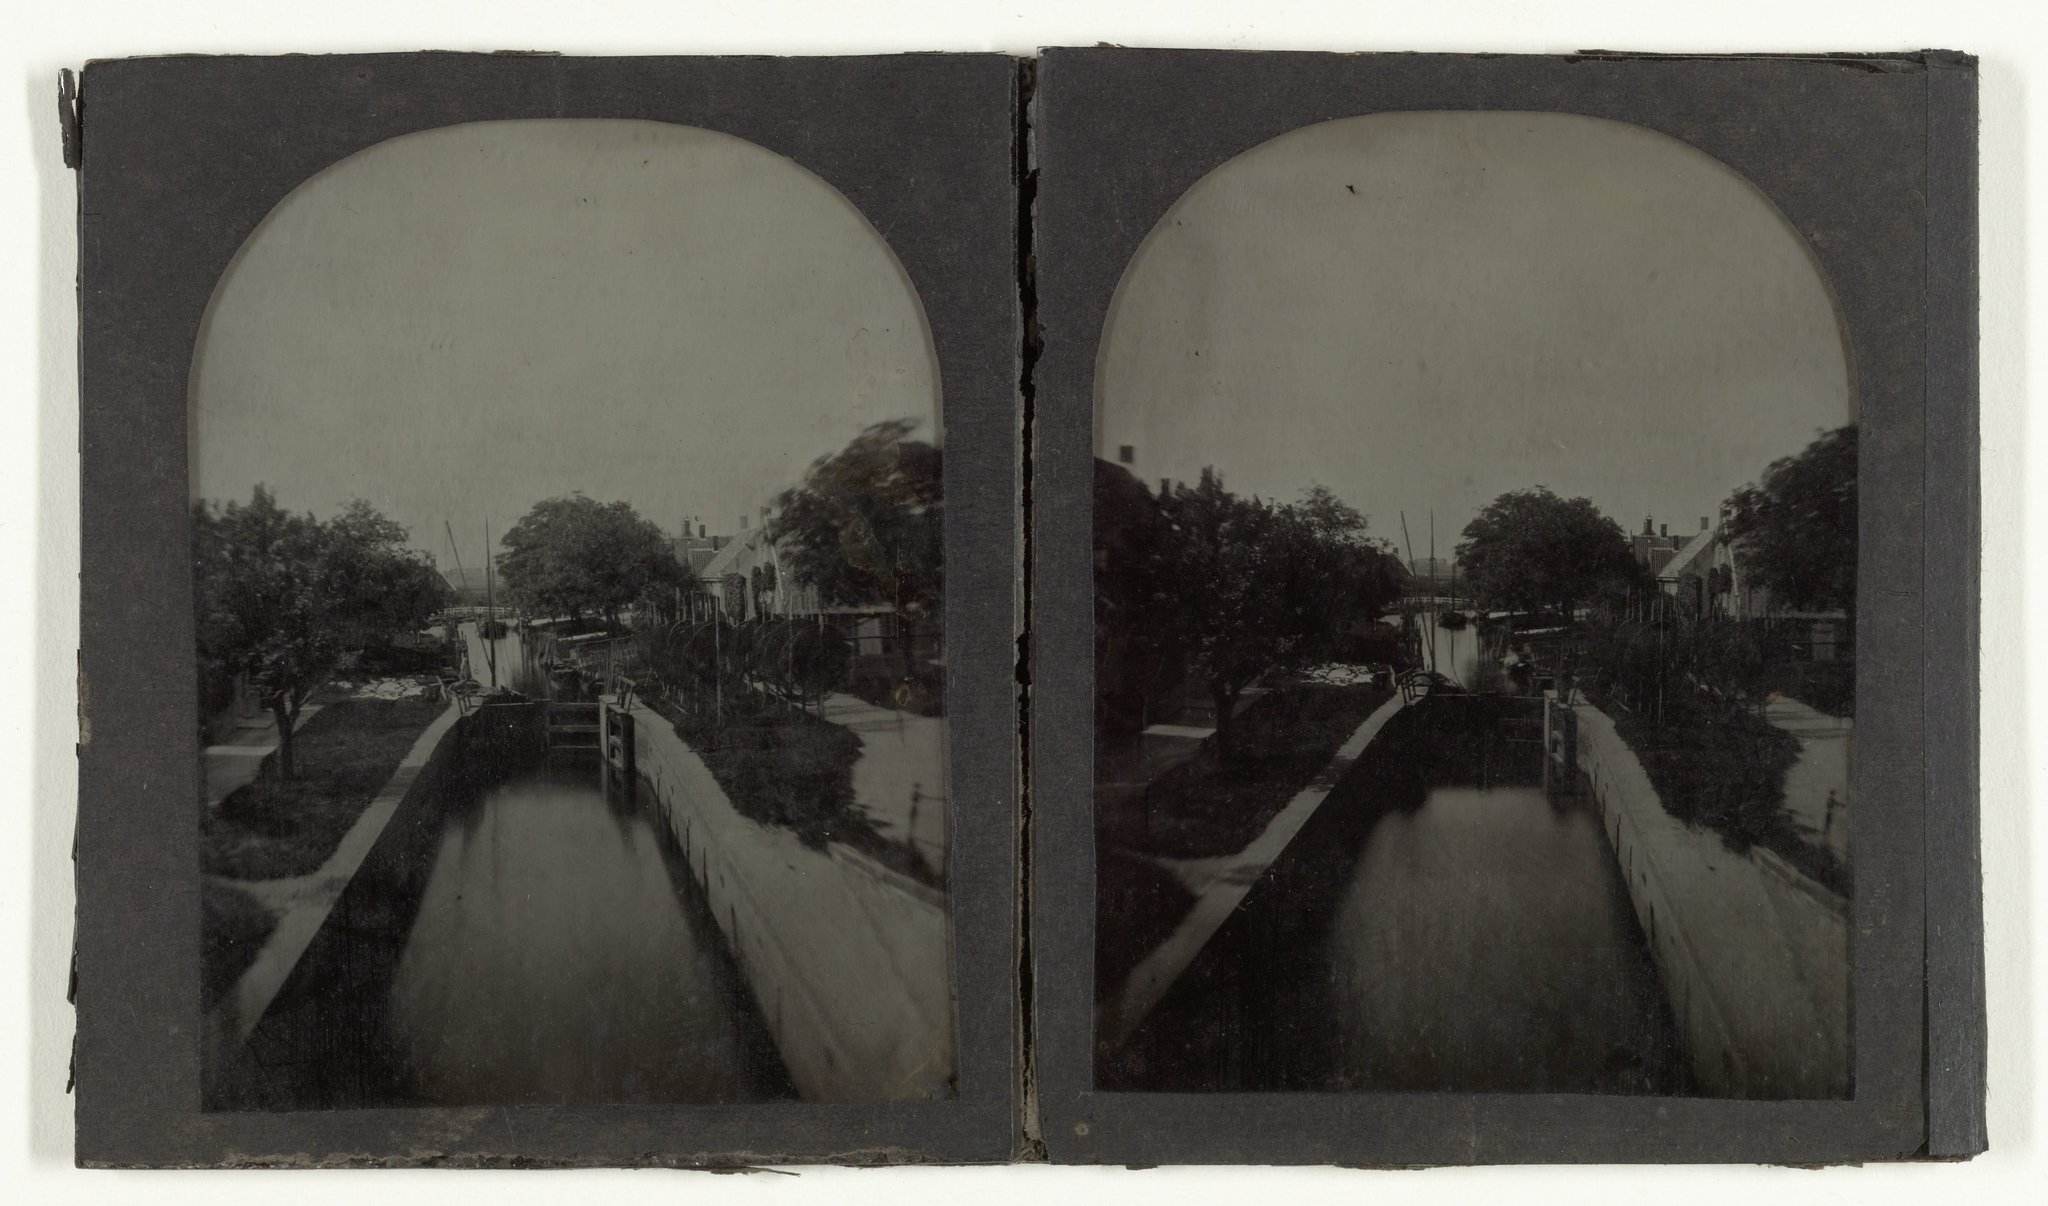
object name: stereograph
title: Nederlands dorpsgezicht, haven met sluis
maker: Anonymous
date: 1854-1880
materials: glass, paper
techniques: ambrotype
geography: netherlands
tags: harbour, netherlands